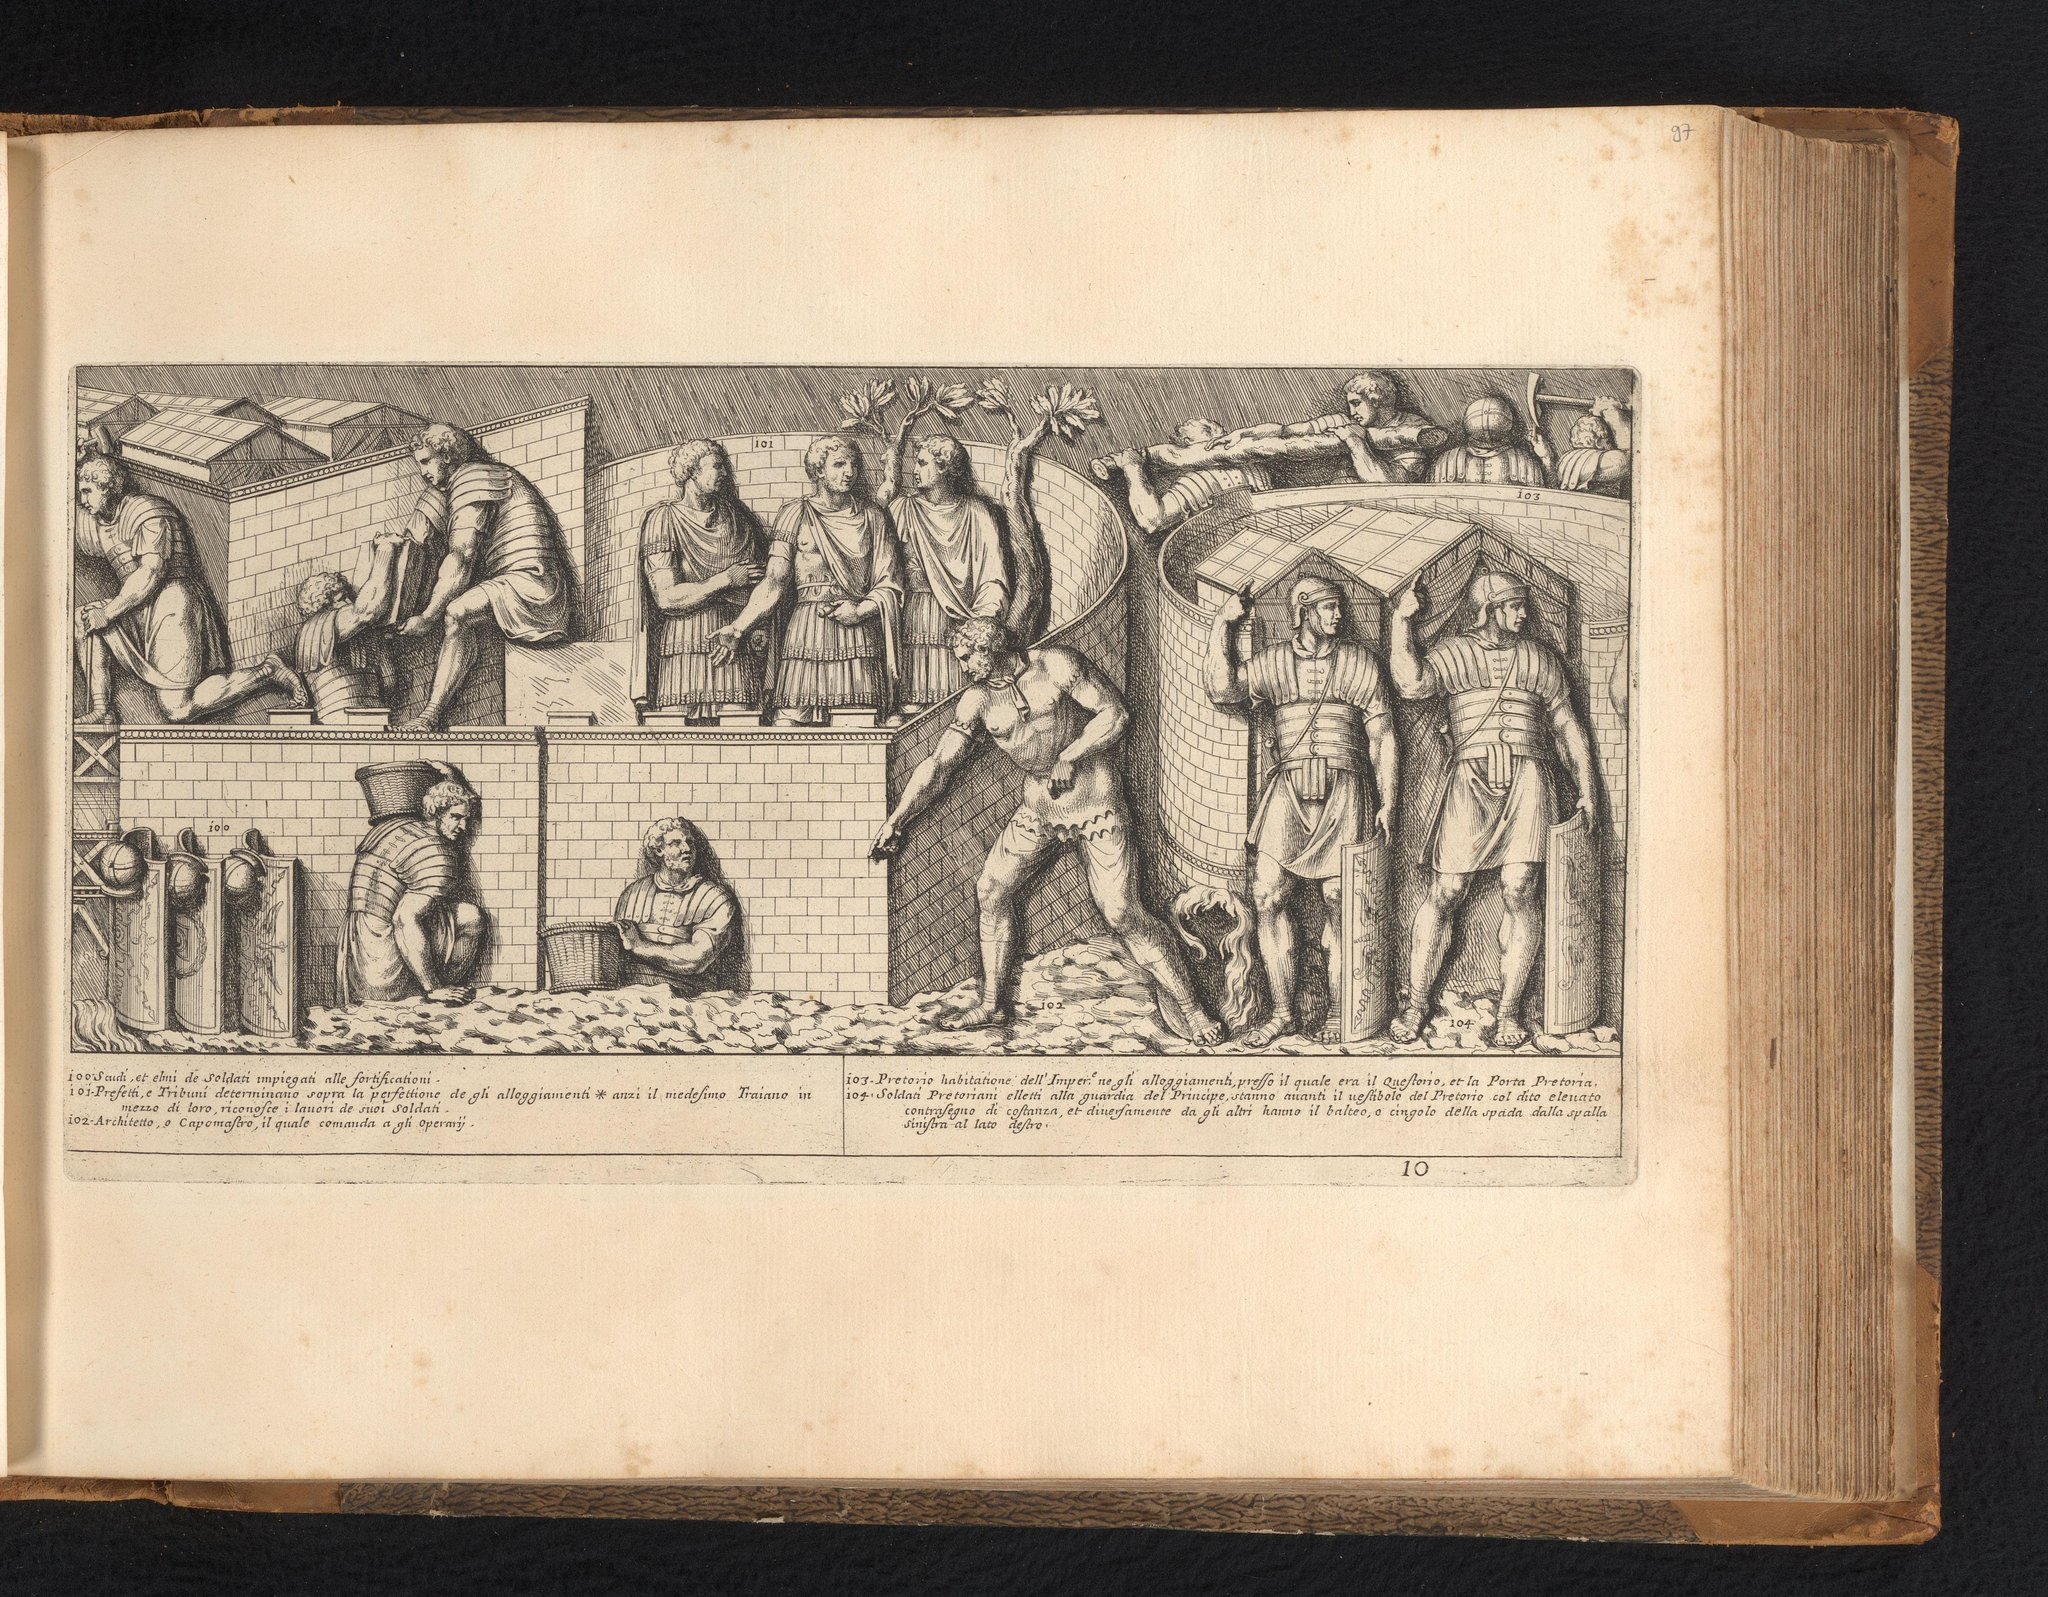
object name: print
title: Colonna Traiana eretta dal senato, e popolo Romano all' imperatore Traiano Augusto nel suo foro in Rom (...)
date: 1637-1691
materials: paper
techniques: etching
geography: rome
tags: triumphal column with helical friezes, piece of sculpture, reproduction of a piece of sculpture, the soldier; the soldier's life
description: Detail van het spiraalvormige gebeeldhouwde fries op de Zuil van Trajanus. Het fries toont de oorlogen tussen de Romeinen en de Daciërs. Verklarende nummers in de ondermarge. Prent maakt deel uit van een album.